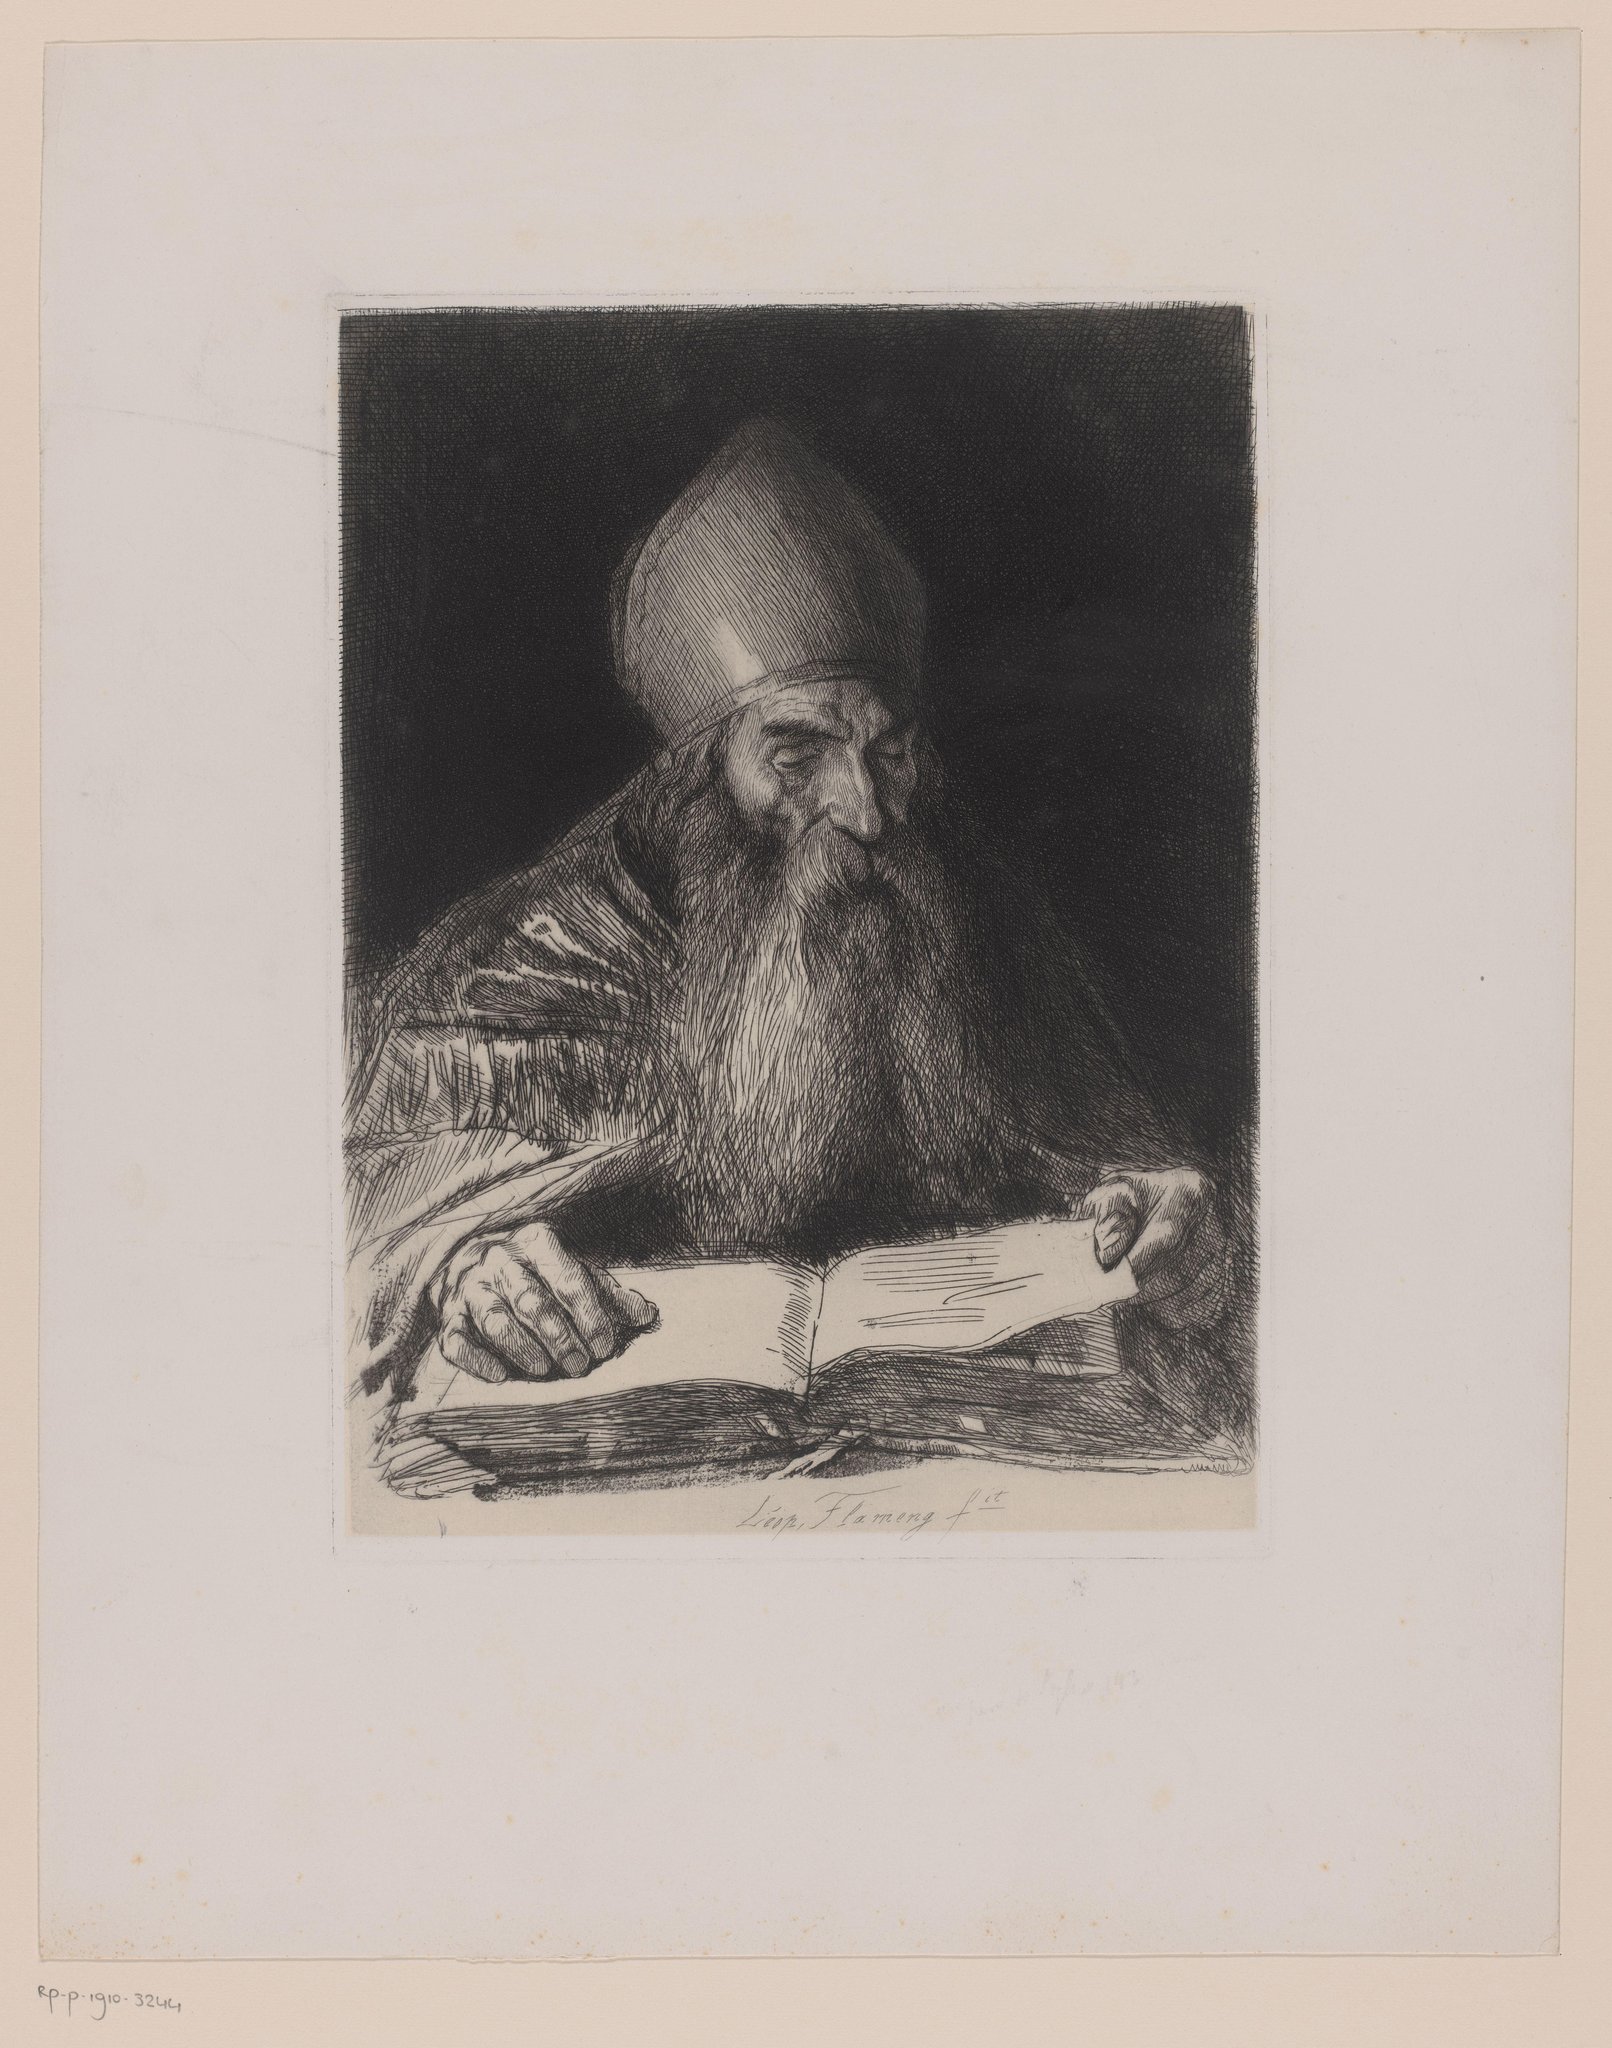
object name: print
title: Bebaarde man met een mijter op leest in een boek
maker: léopold flameng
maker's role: print maker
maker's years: 1831-1911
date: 1841-1910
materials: paper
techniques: drypoint, etching, intaglio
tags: insignia of bishop, e.g. mitre, crozier, reading the bible or other religious books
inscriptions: collector's mark: Lugt 2228